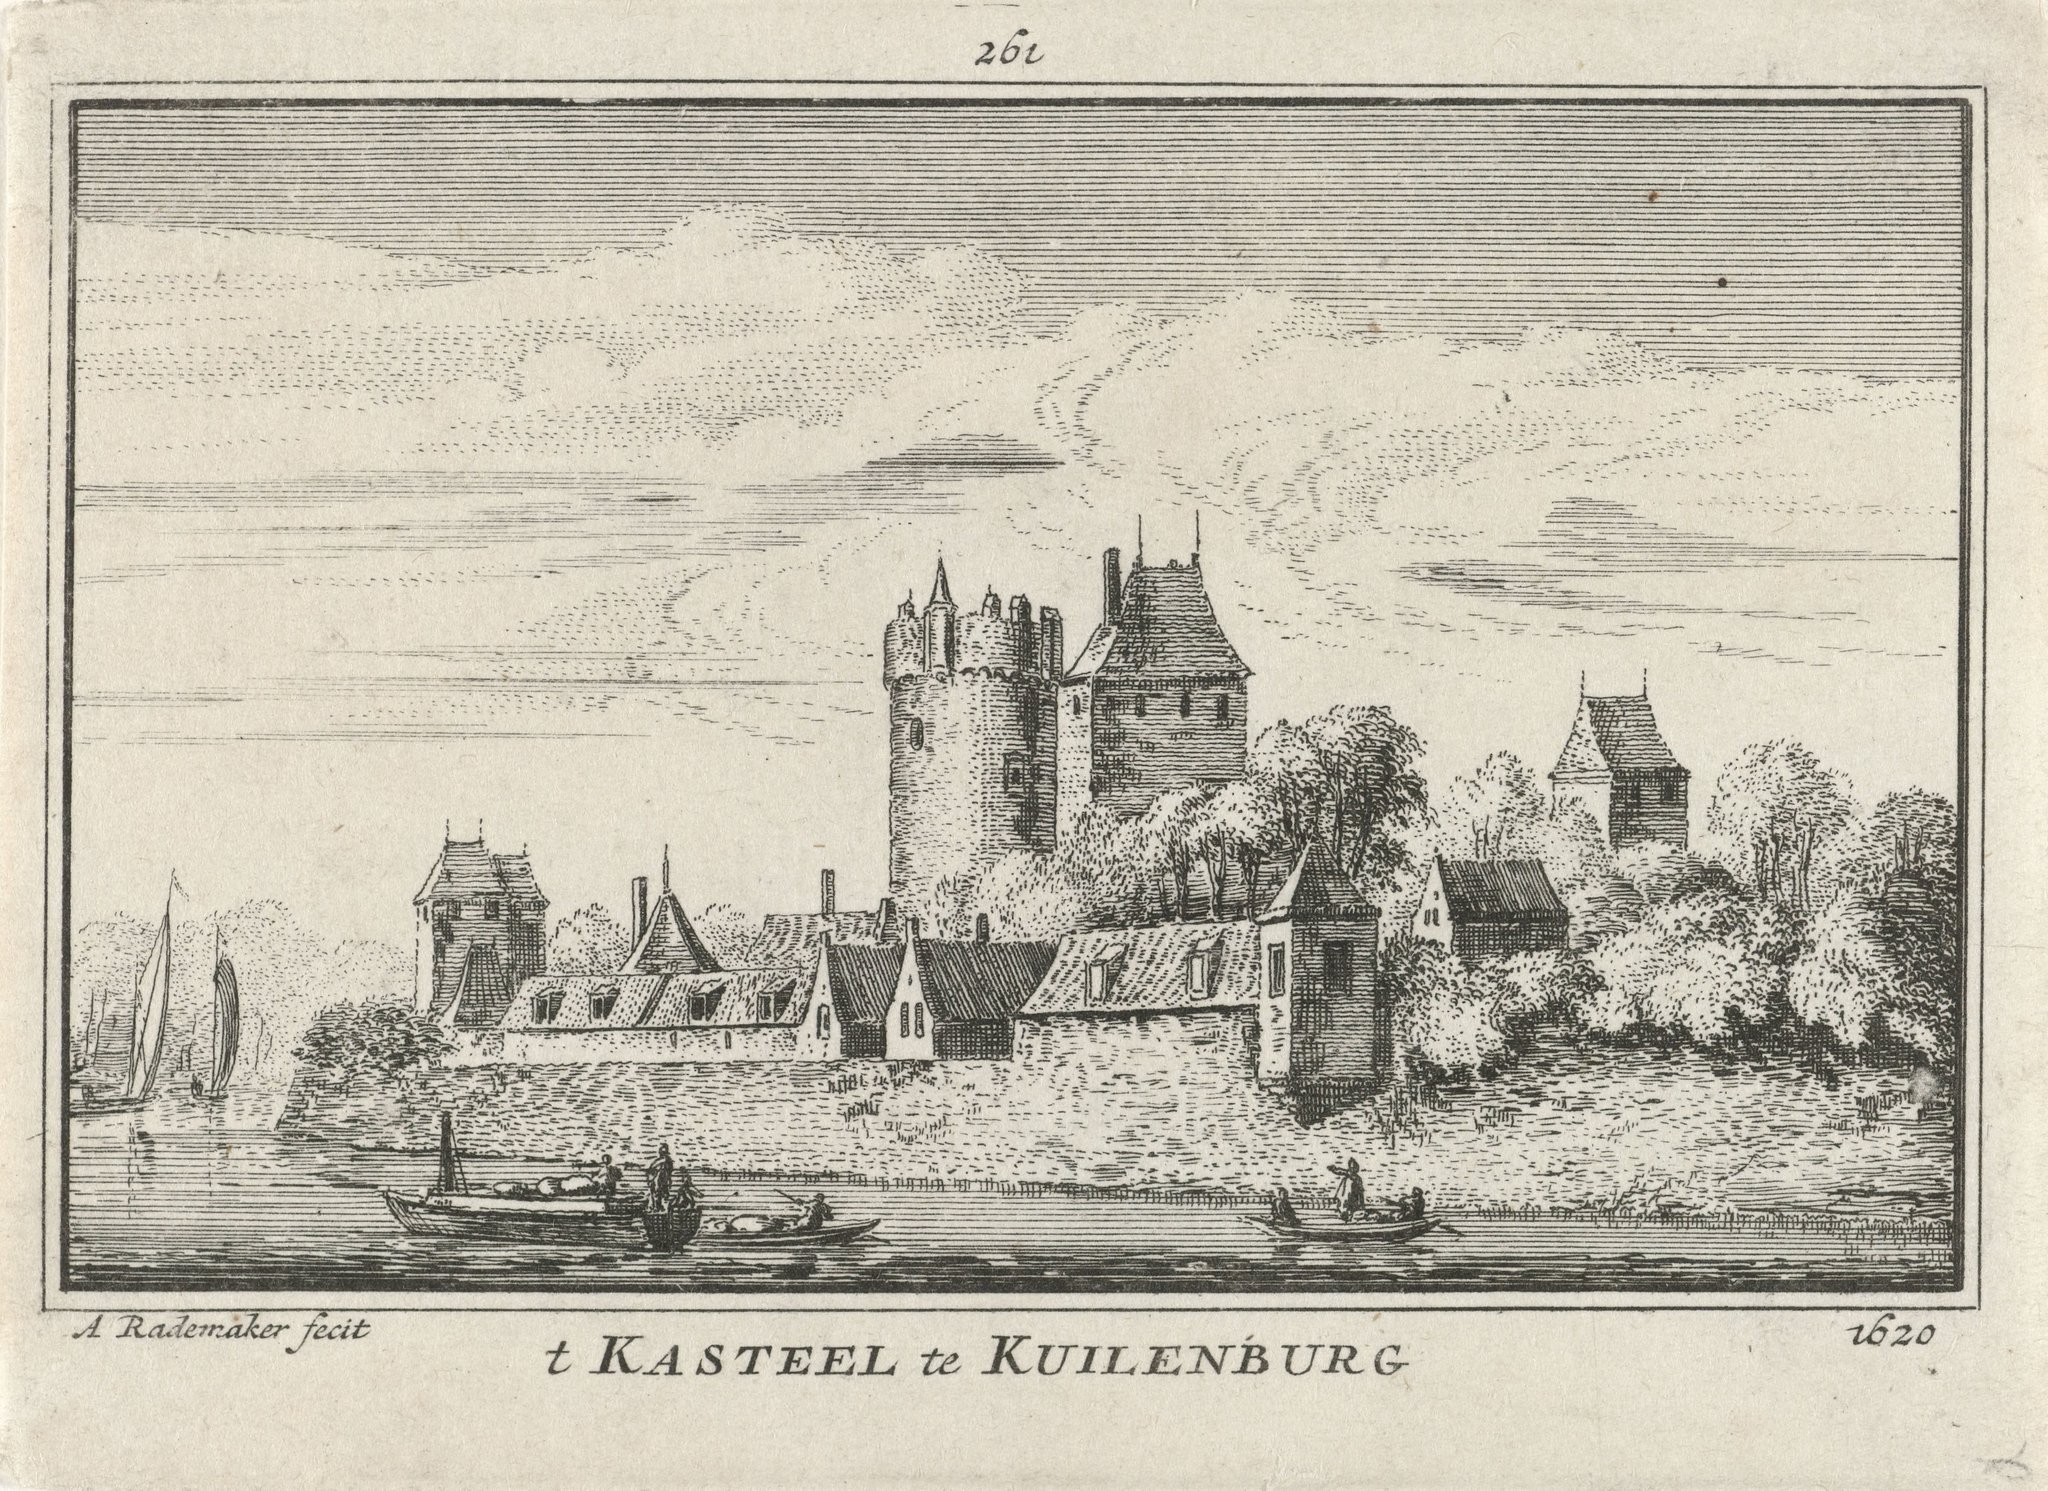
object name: book illustration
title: t Kasteel te Kuilenburg 1620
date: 1727-1733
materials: paper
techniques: etching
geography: amsterdam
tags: sailing-ship, sailing-boat, castle, rowing-boat, canoe, etc.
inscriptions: collector's mark: Lugt 2228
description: Illustratie uit: Abraham Rademaker, Matthaeus Brouërius van Niedek, Isaac Le Long, Kabinet van Nederlandsche en Kleefsche outheden en (...) voorname stads- en landgebouwen, Willem Barents en Antoni Schoonenburg: Amsterdam, 1727-1733, ill. nr. 261.